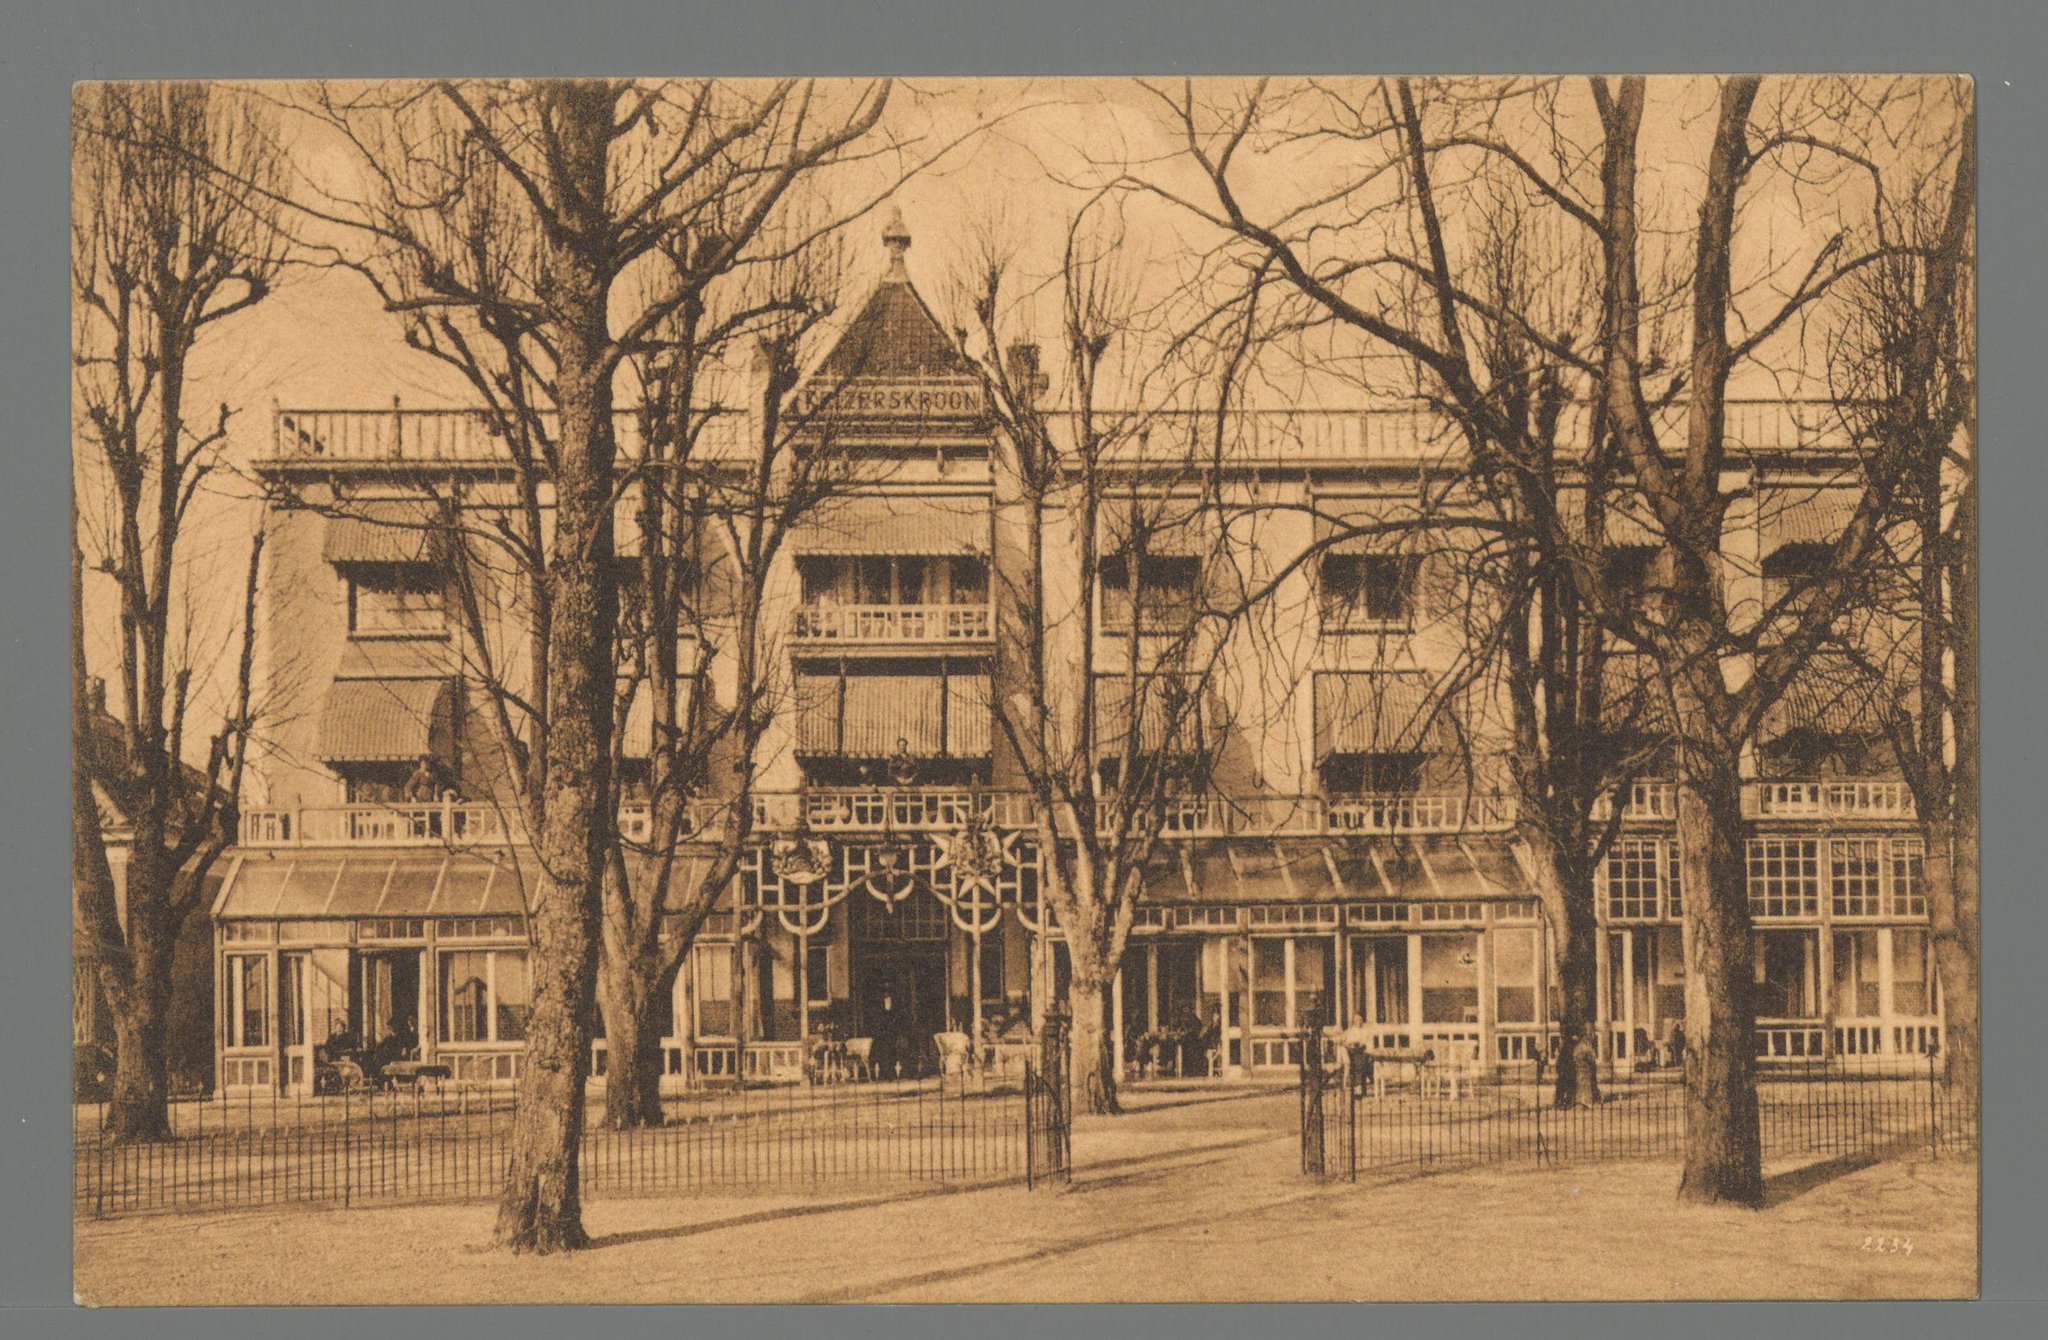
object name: ansichtkaart, prentbriefkaart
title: Hotel "De Keizerskroon"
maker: Anonymous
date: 1905-1930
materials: cardboard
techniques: photograph, writing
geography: apeldoorn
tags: hotel, hostelry, inn